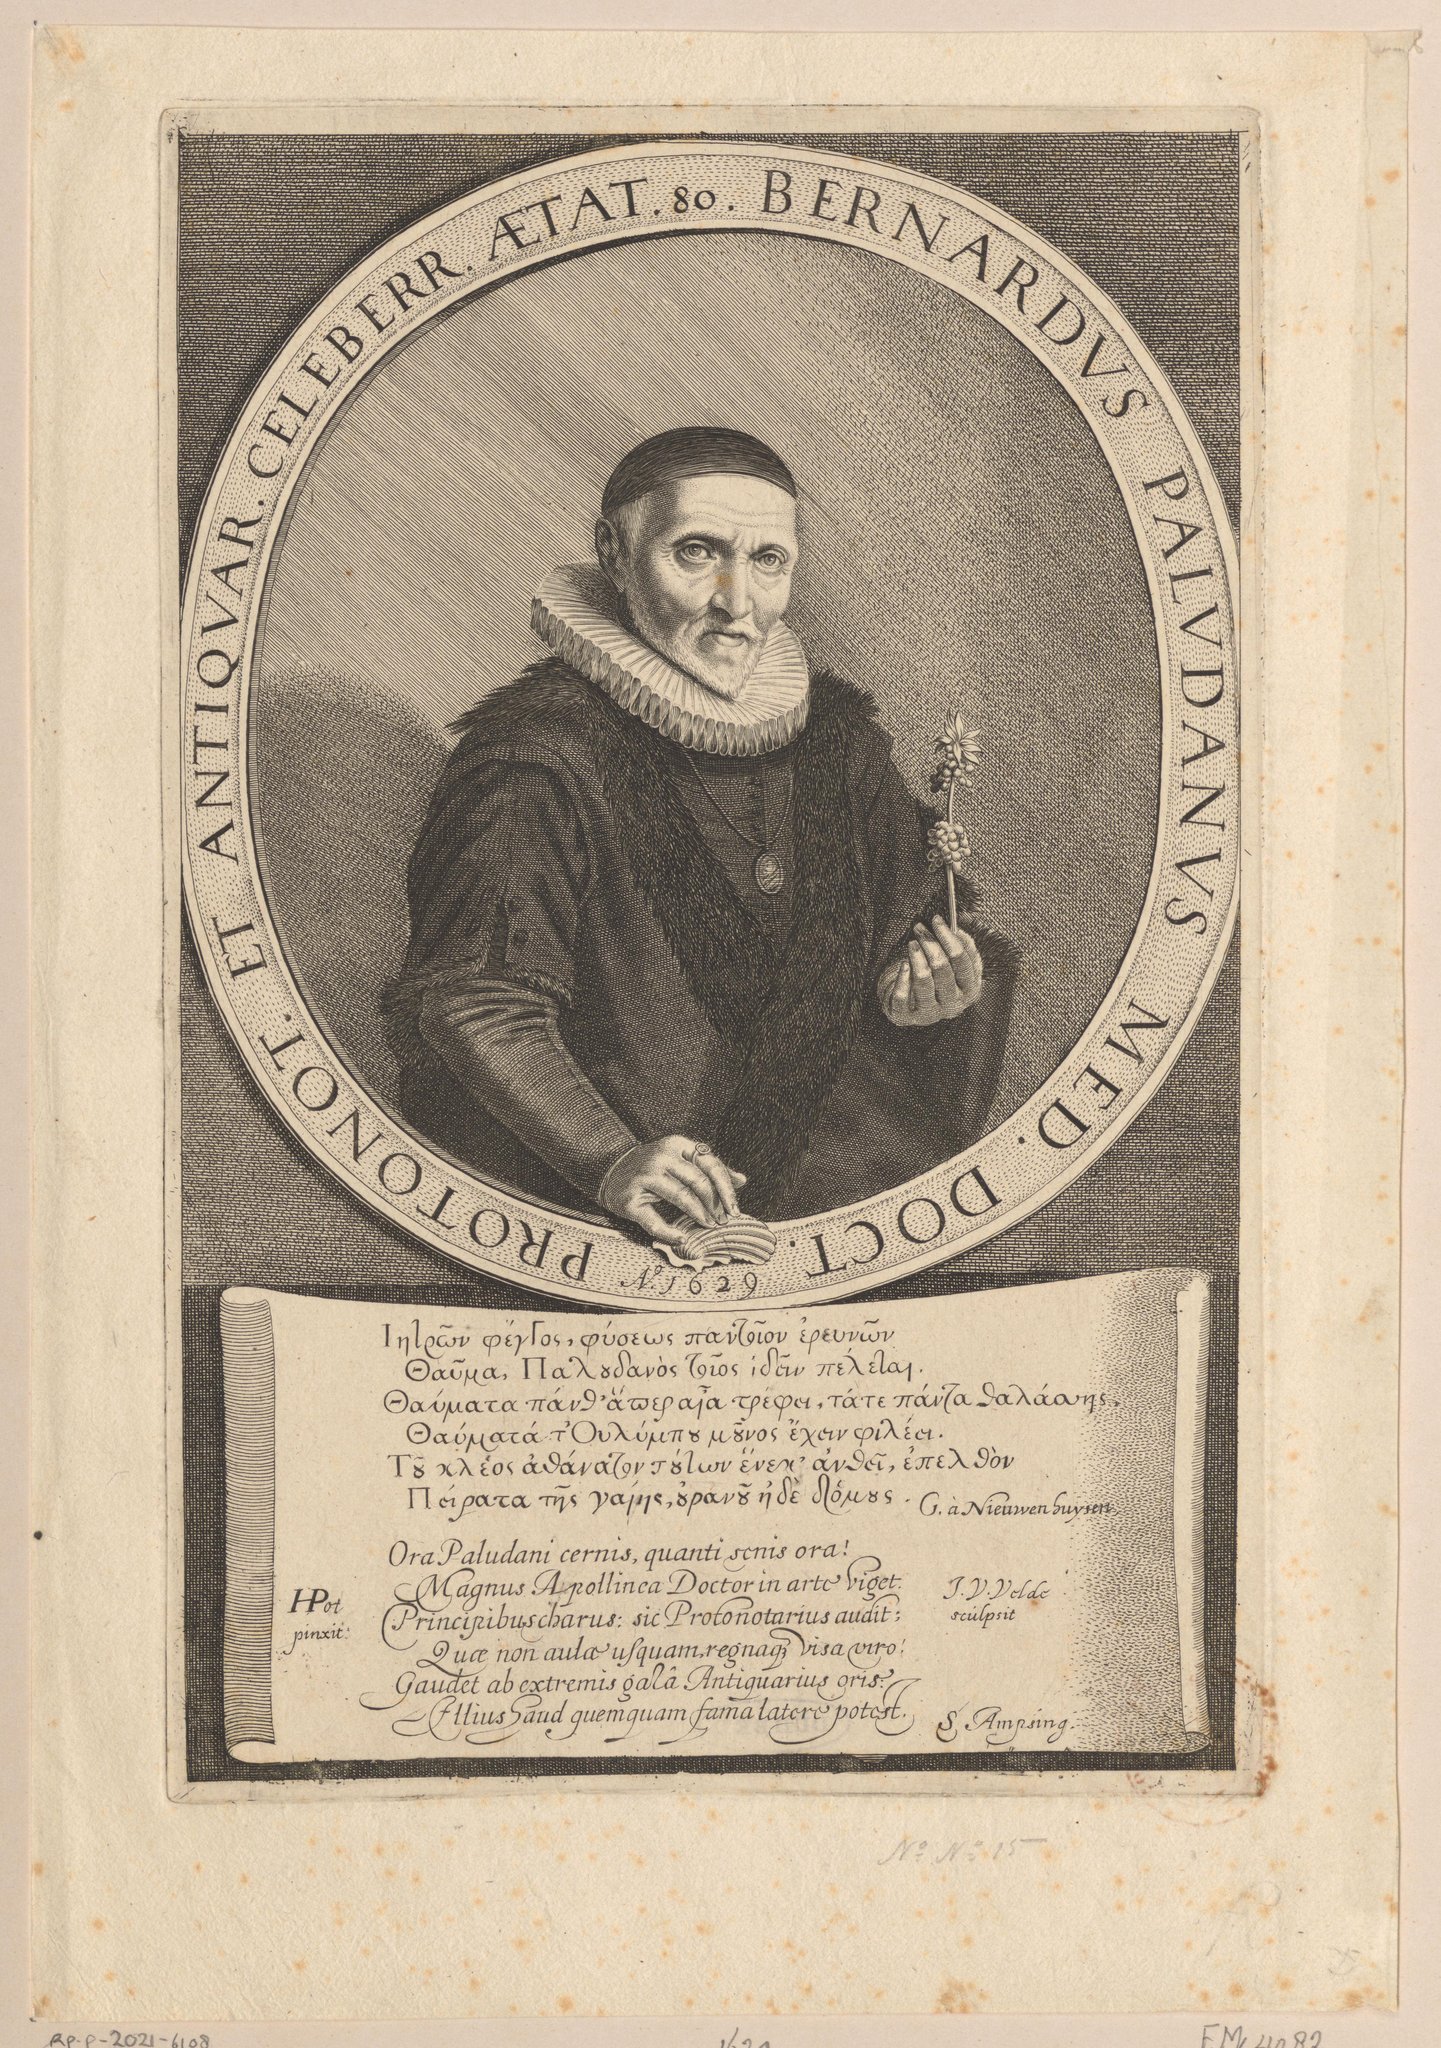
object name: print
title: Portret van Bernardus Paludanus op 80-jarige leeftijd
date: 1629-1641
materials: paper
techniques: engraving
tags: adult man, historical persons, (oyster) shell ~ attribute of pilgrim(s)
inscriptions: mark: Lugt 698, collector's mark: Lugt 240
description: In zijn hand een tak en onder zijn andere hand een sint-jakobsschelp. Onderschrift in het Grieks en Latijn.